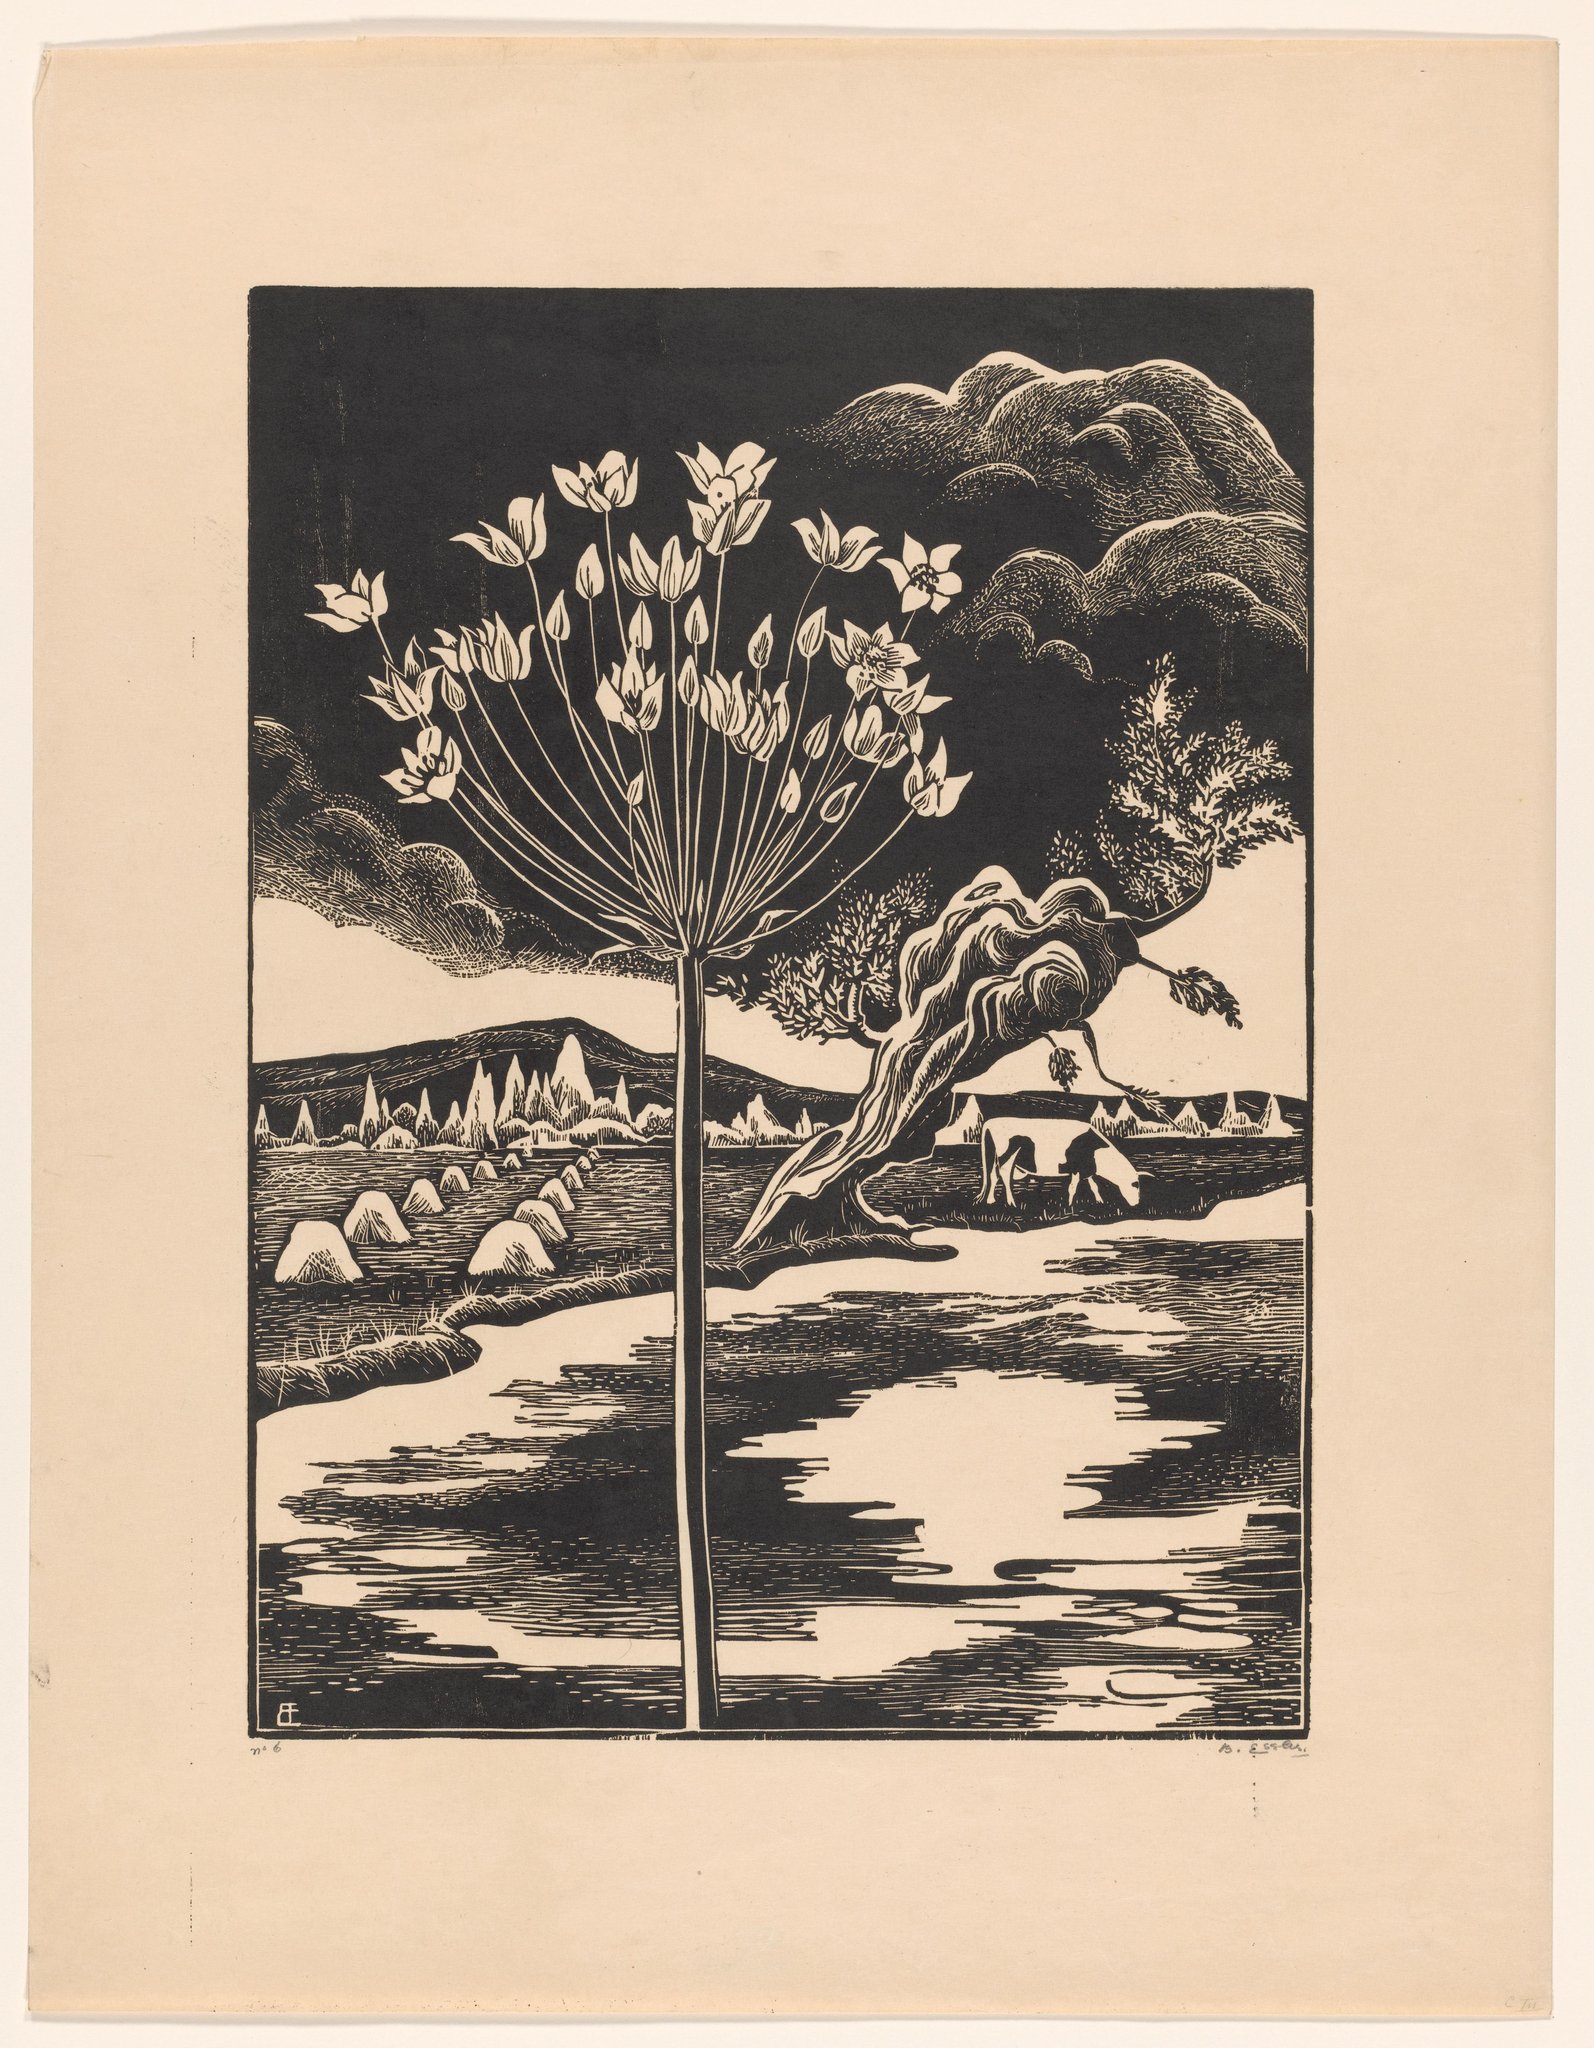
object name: print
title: Zwanebloem in een landschap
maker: bernard essers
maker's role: print maker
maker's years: 1893-1945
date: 1937-1938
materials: paper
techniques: woodcut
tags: flowers, cow, landscapes in the temperate zone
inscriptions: collector's mark: Lugt 2228, inscription: ‘No. 6’